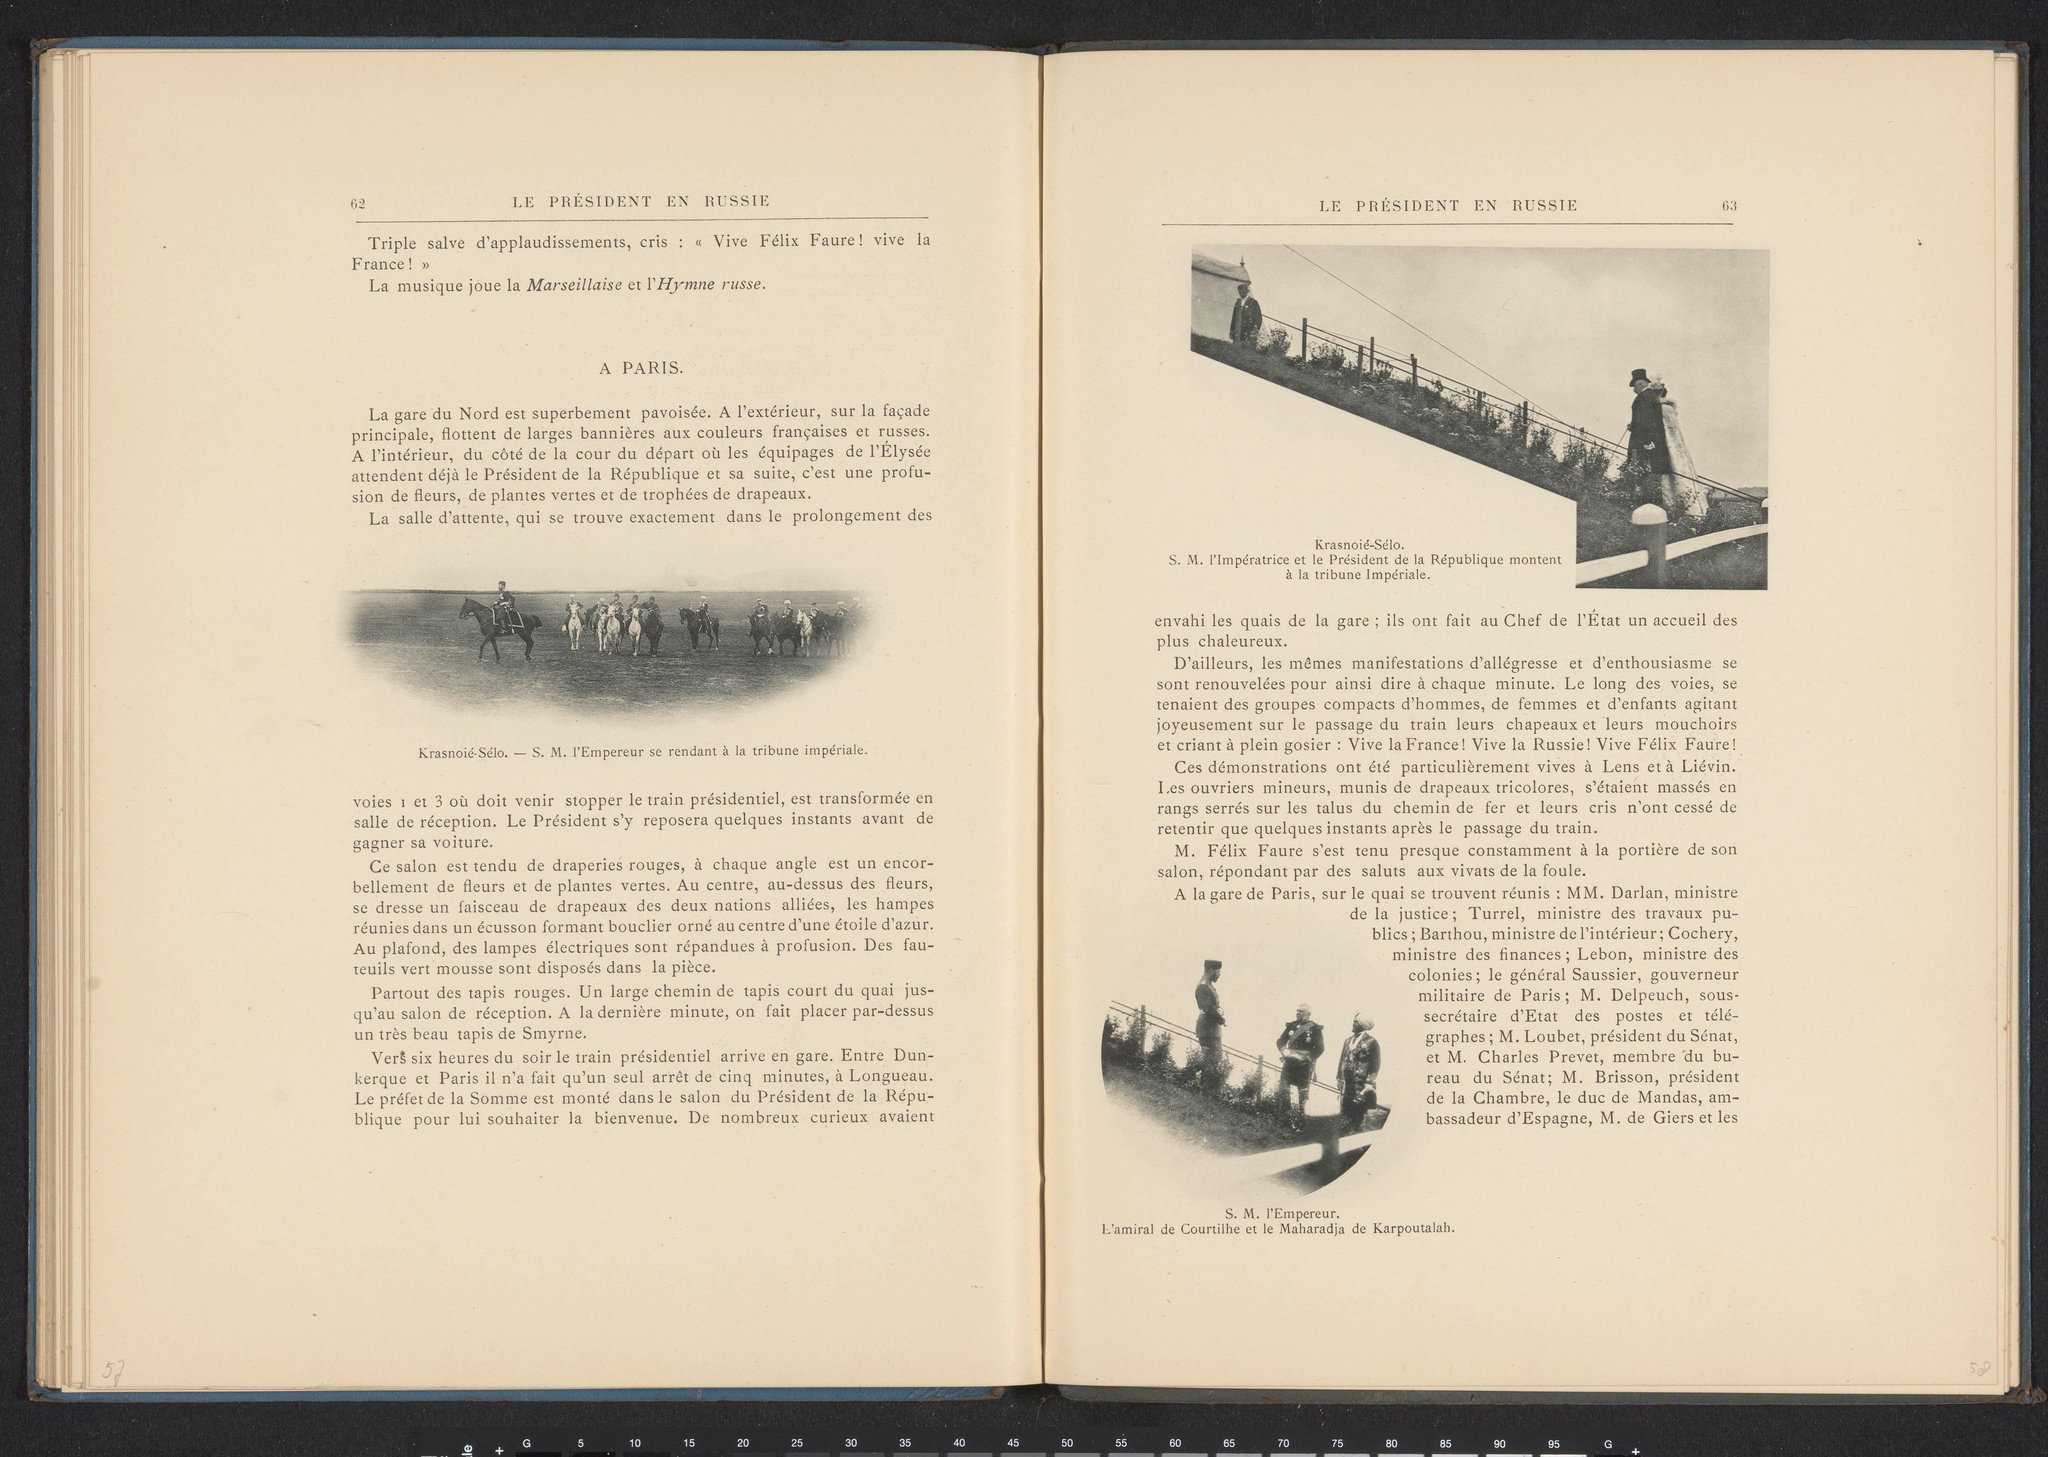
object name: page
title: Tsaar Nicolaas II van Rusland en zijn gevolg te paard te Krasnoye Selo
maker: Anonymous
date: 1897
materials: paper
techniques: photograph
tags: riding a horse, ass, or mule; rider, horseman, ruler, sovereign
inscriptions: inscription: ‘Krasnoié-Sélo-(...) impériale.’